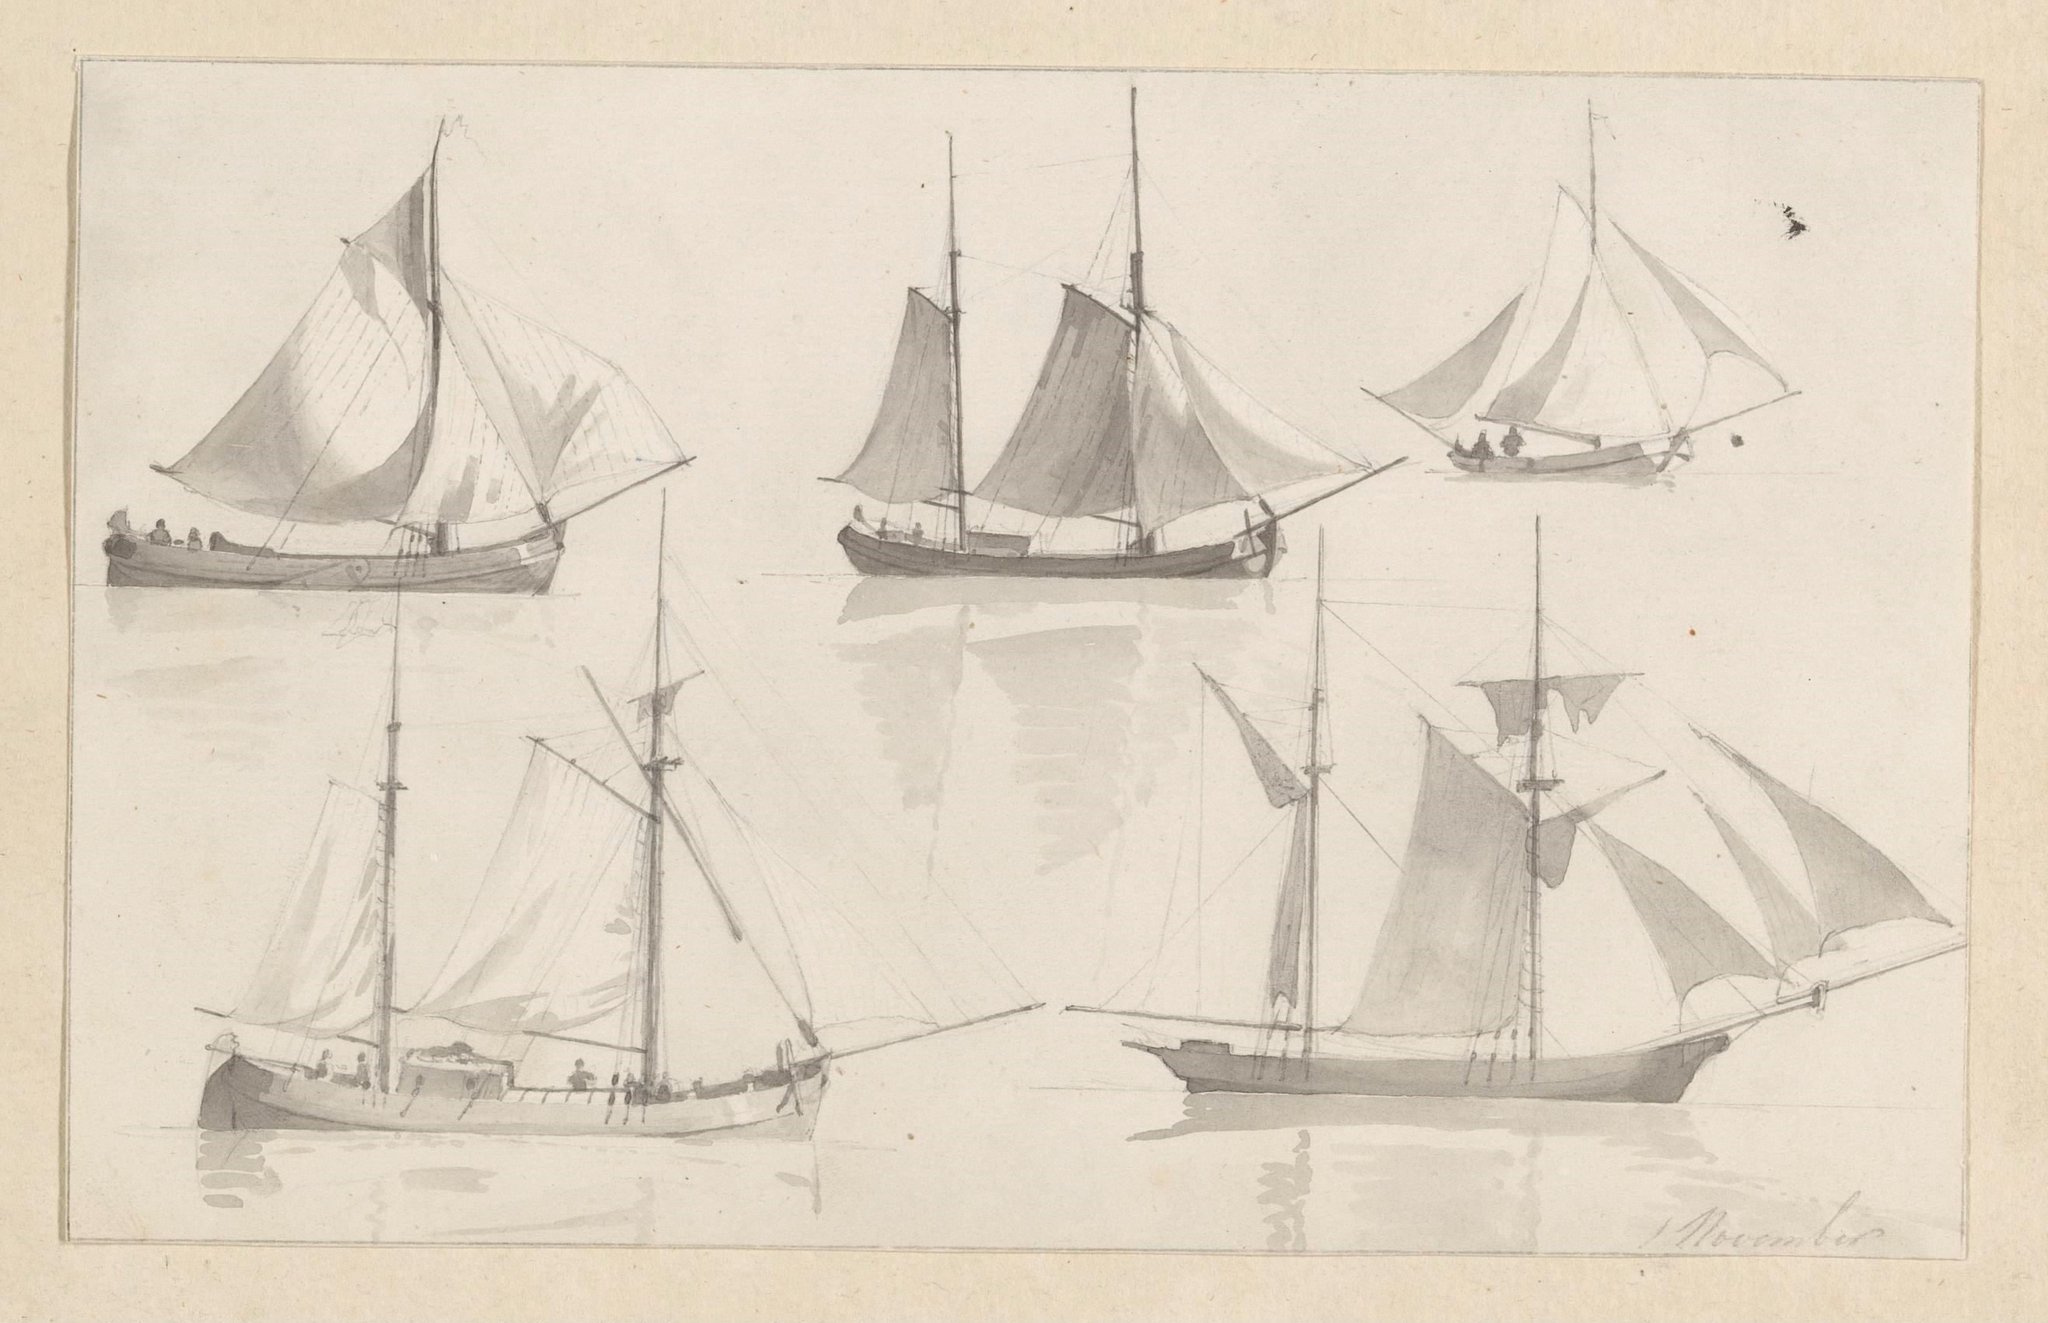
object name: drawing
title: Schetsblad met vijf zeilschepen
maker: hendrik abraham klinkhamer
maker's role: draughtsman, painter, print maker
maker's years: 1810-1872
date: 1820-1872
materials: paper, pencil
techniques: brush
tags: sailing-ship, sailing-boat